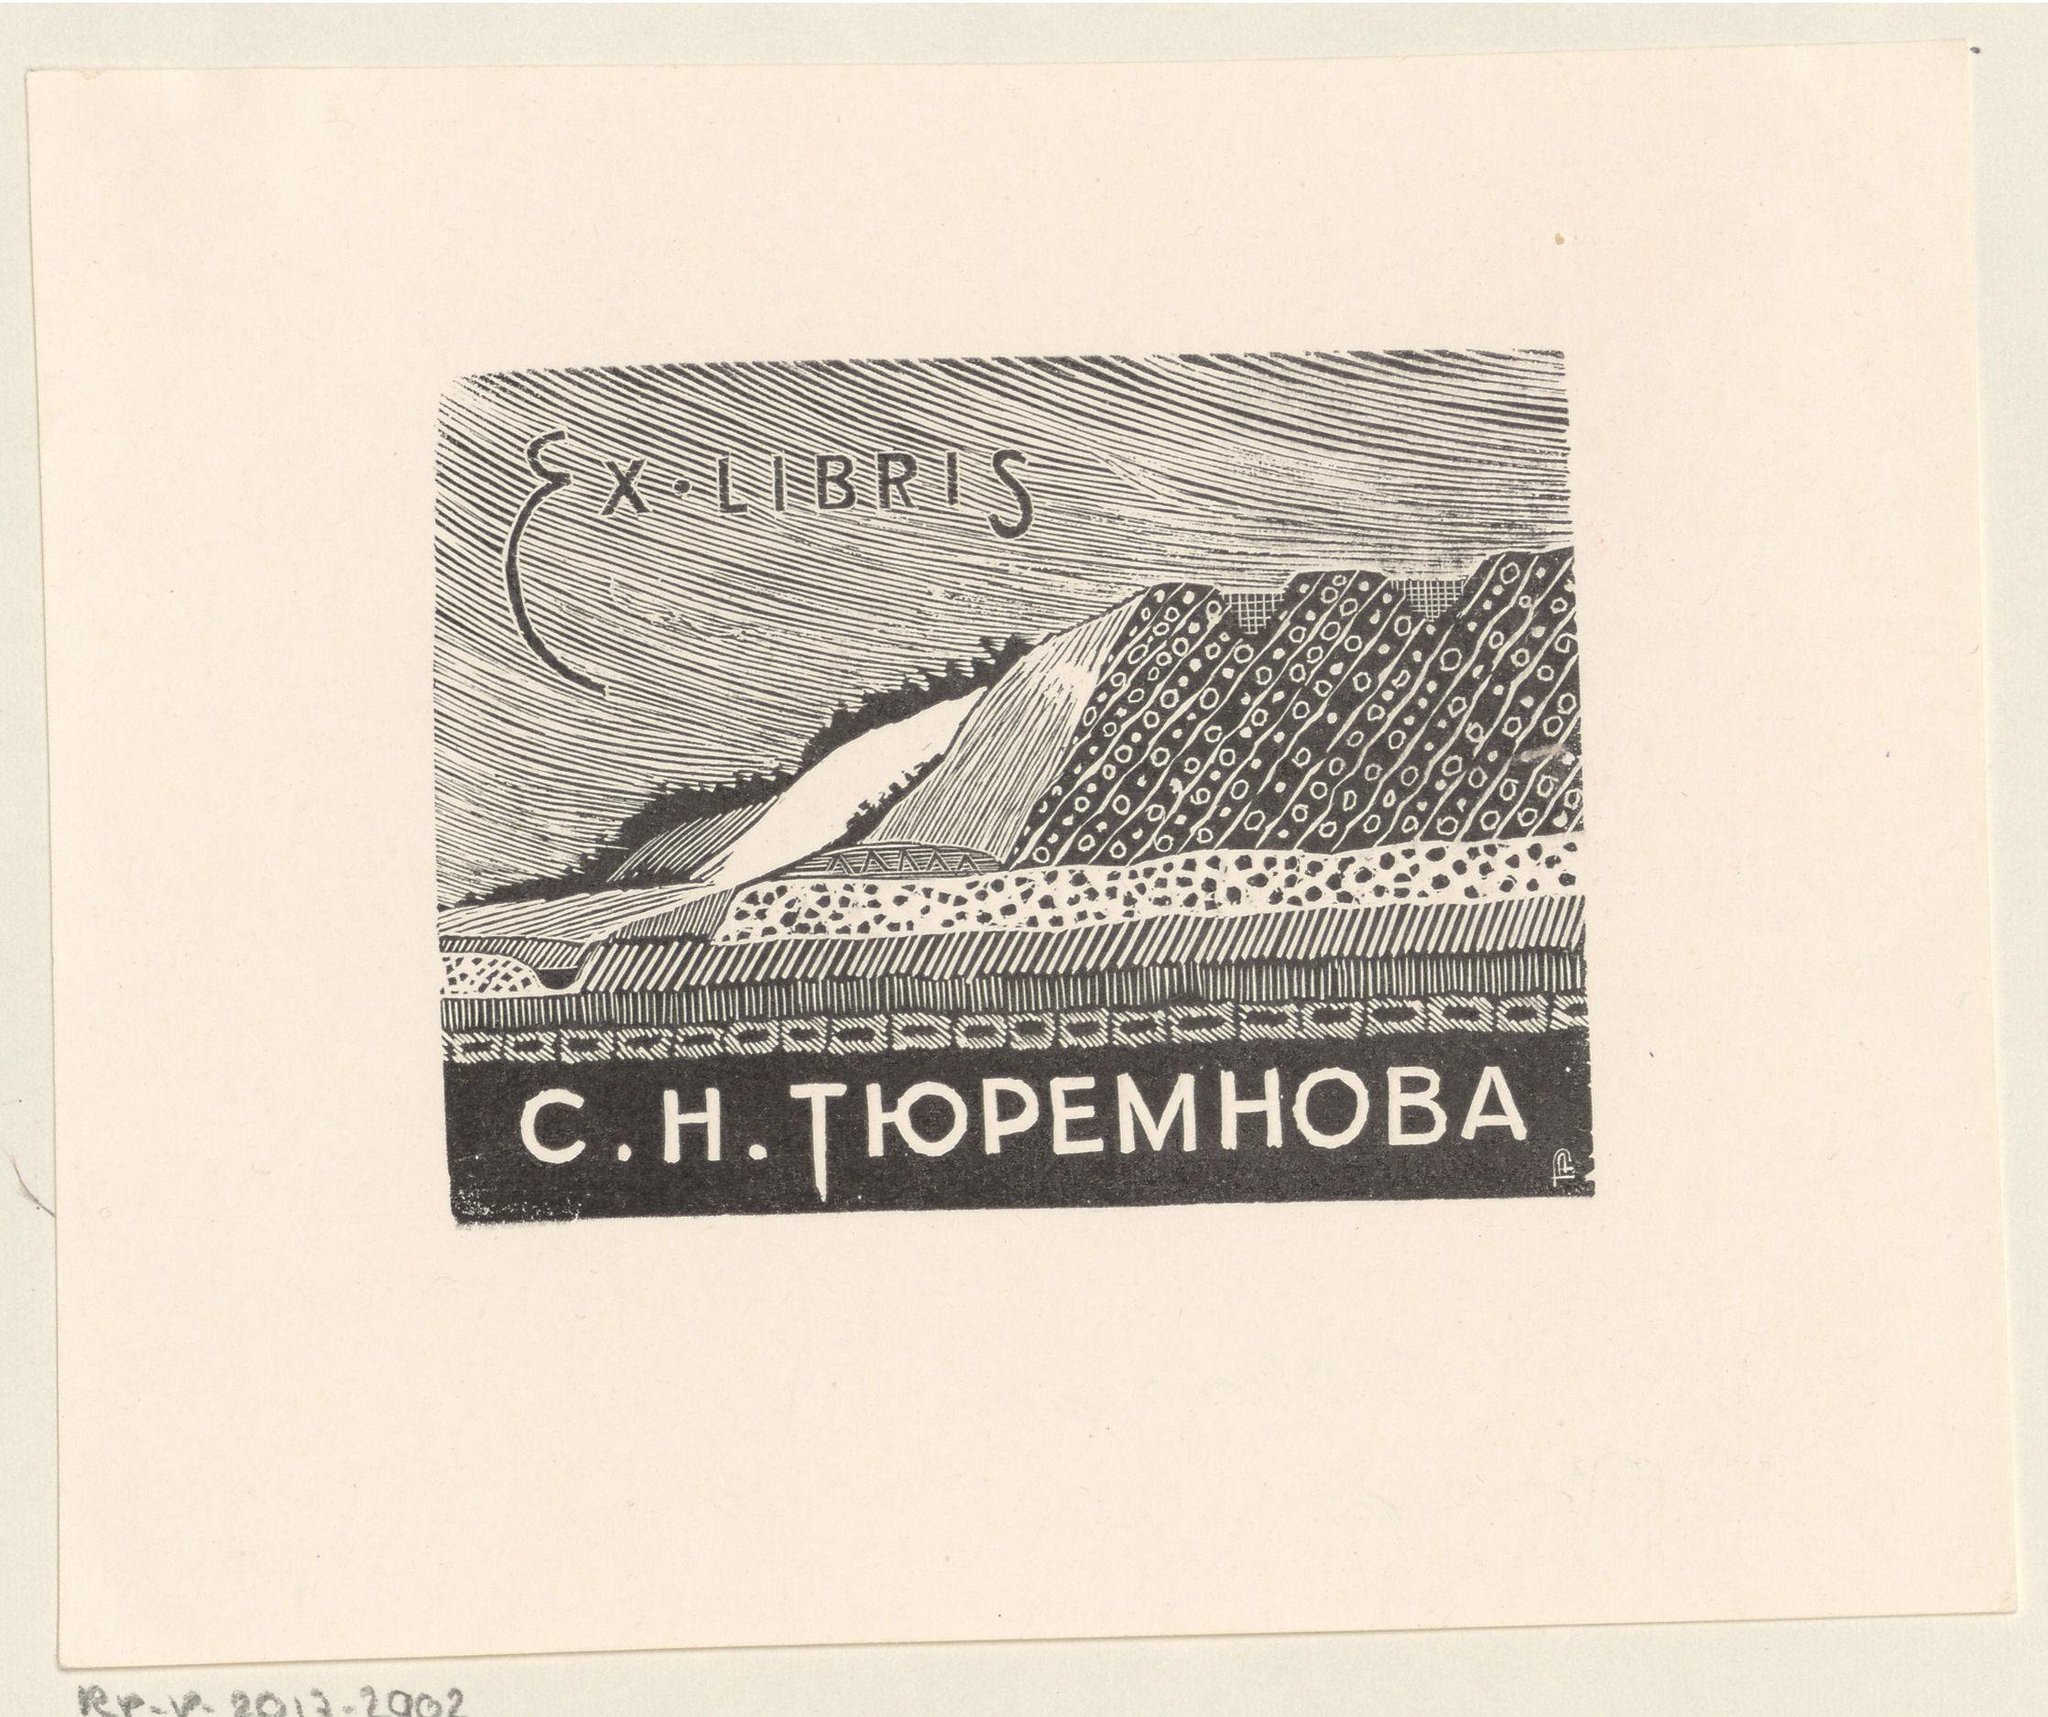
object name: bookplate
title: Ex libris van С.Н. Тюремнова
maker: Anonymous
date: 1959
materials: paper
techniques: woodcut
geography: russia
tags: soil types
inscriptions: inscription: ‘par Тюремнова P.C. (?) / [...]rba [...] 1959’